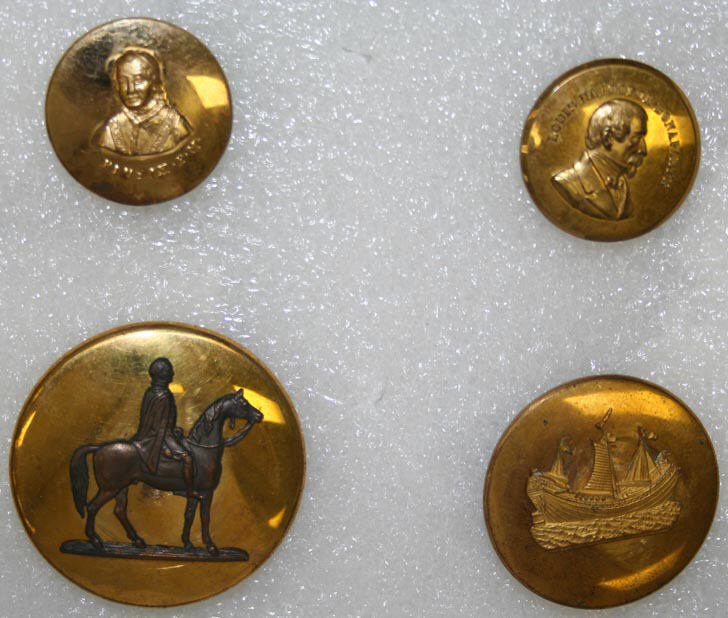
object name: button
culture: british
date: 1850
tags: portraits,profiles,horses,ships